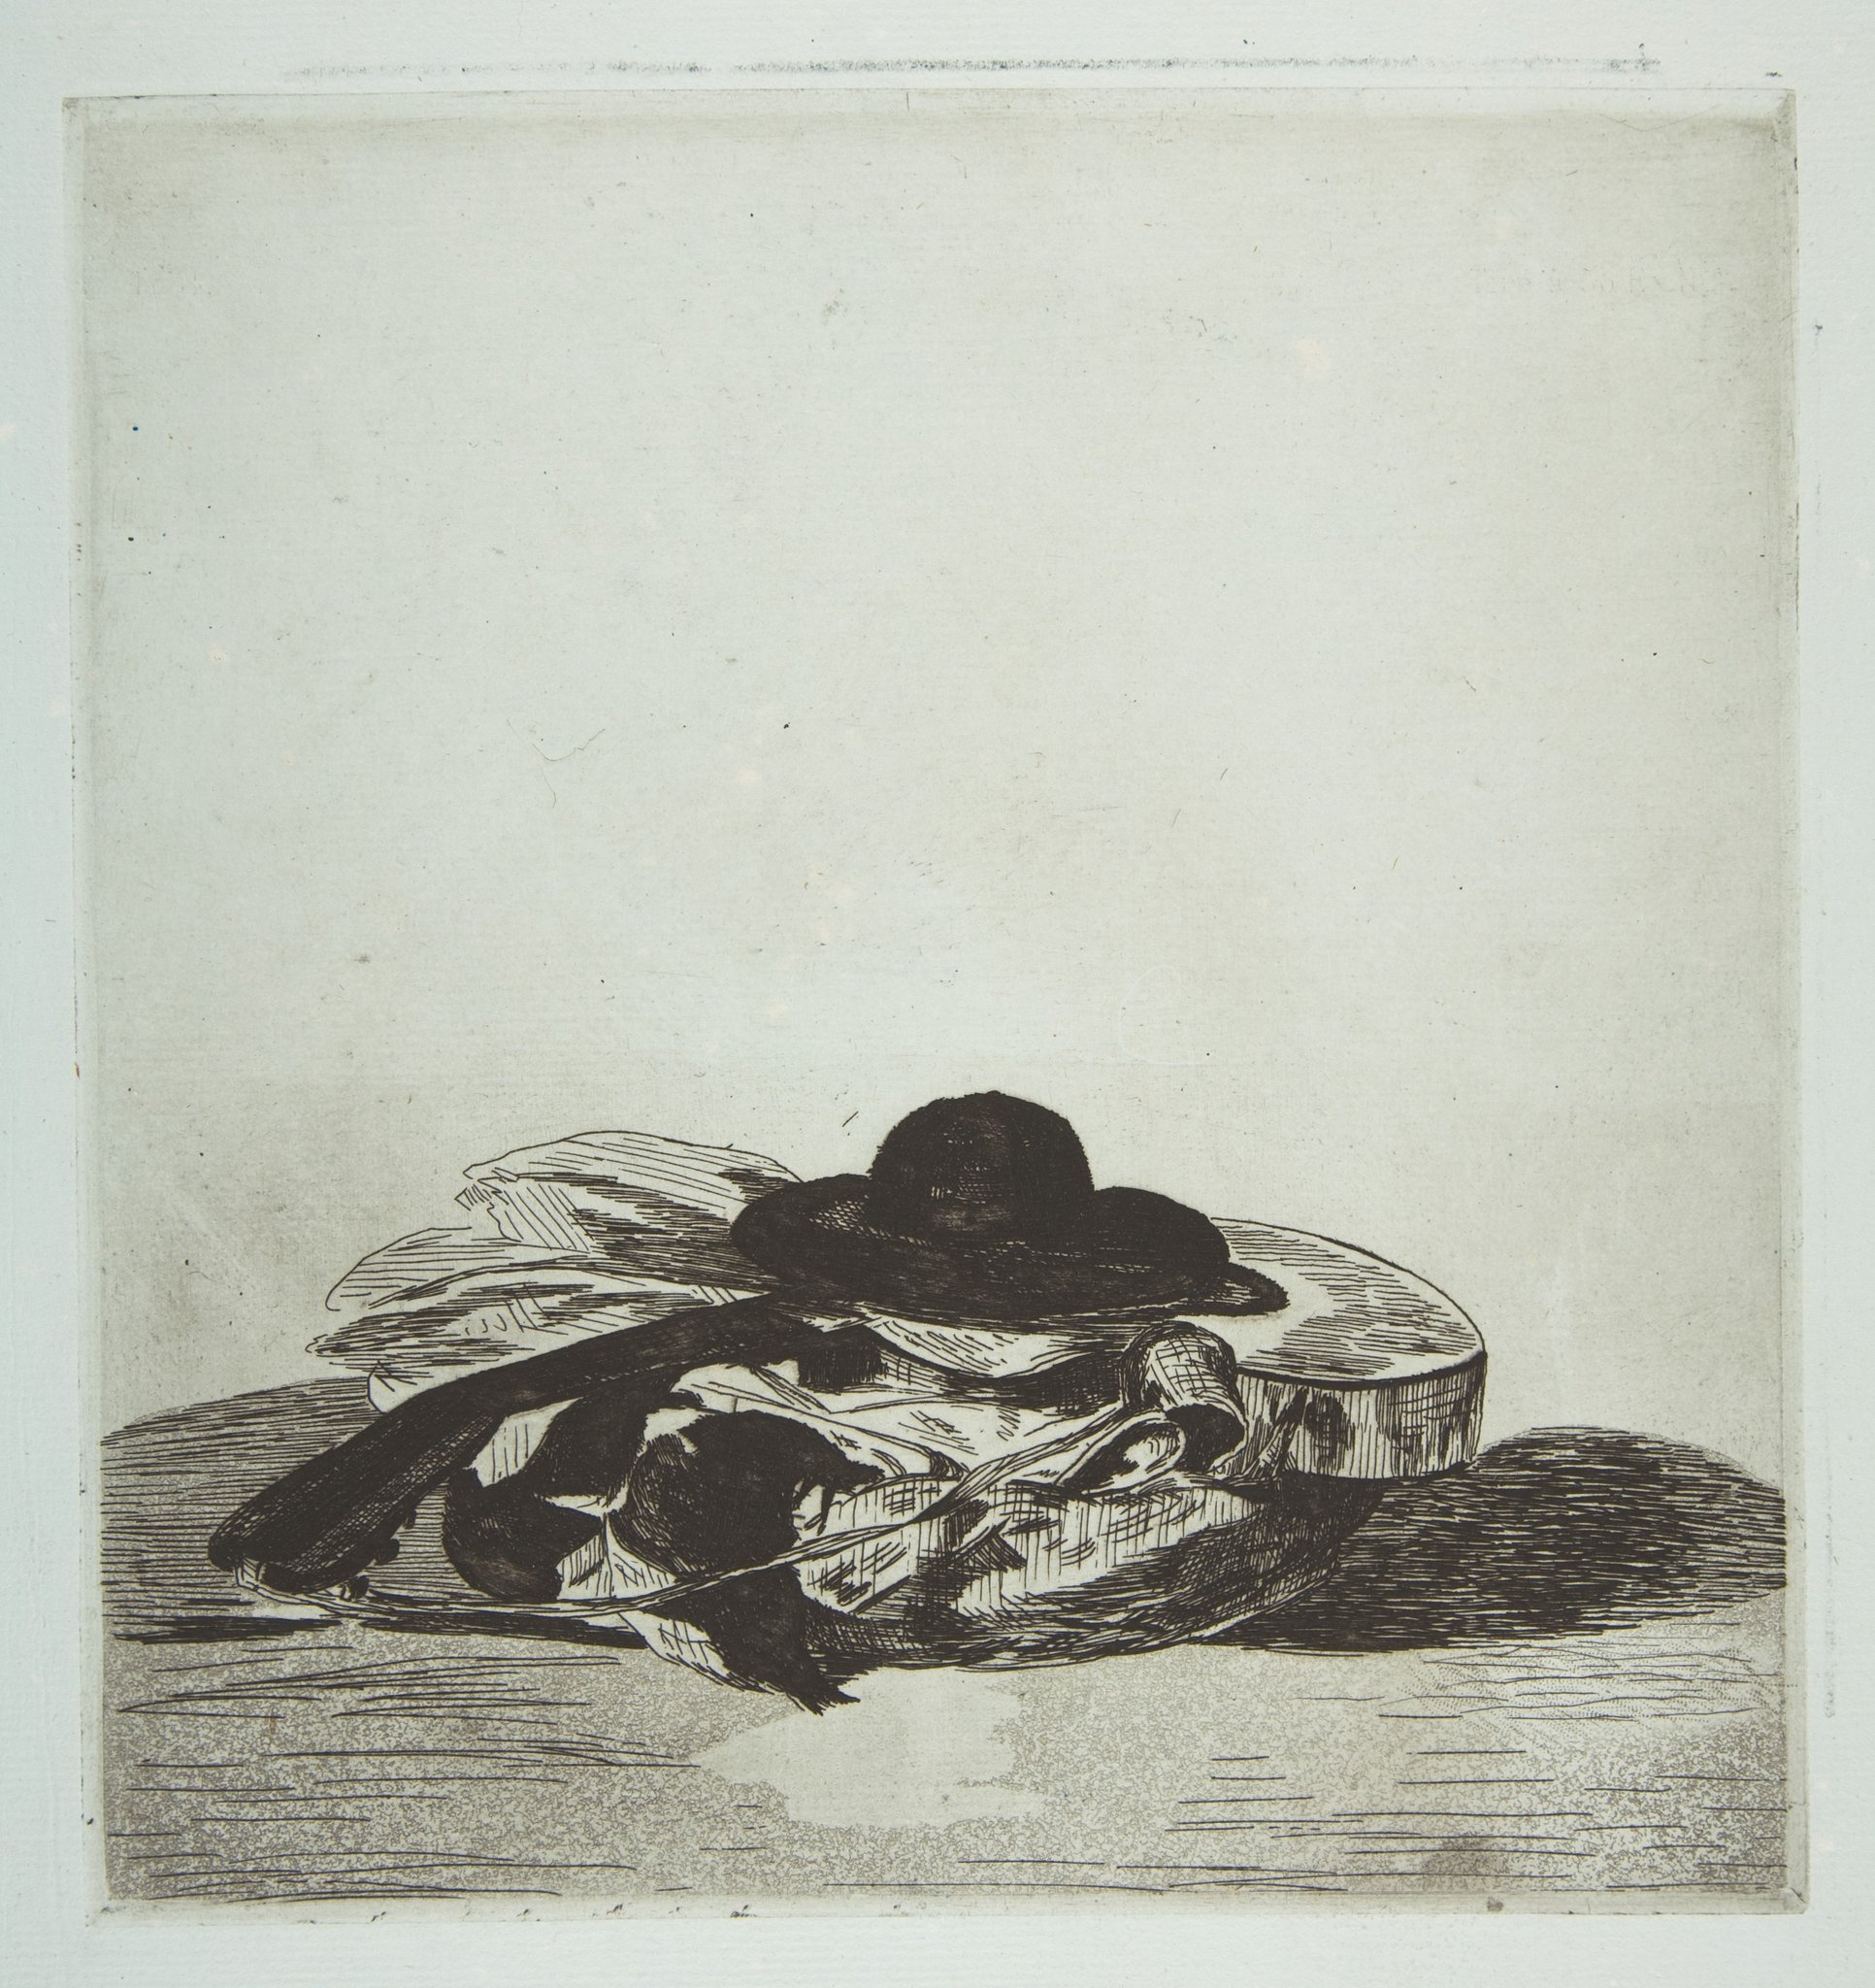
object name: print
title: Hat and Guitar. Cover design for "Eaux-fortes par Edouard Manet," an album of fourteen etchings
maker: édouard manet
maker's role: artist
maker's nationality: french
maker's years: 1832-1883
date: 1862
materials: paper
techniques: aquatint, drypoint, etching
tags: hats,guitars